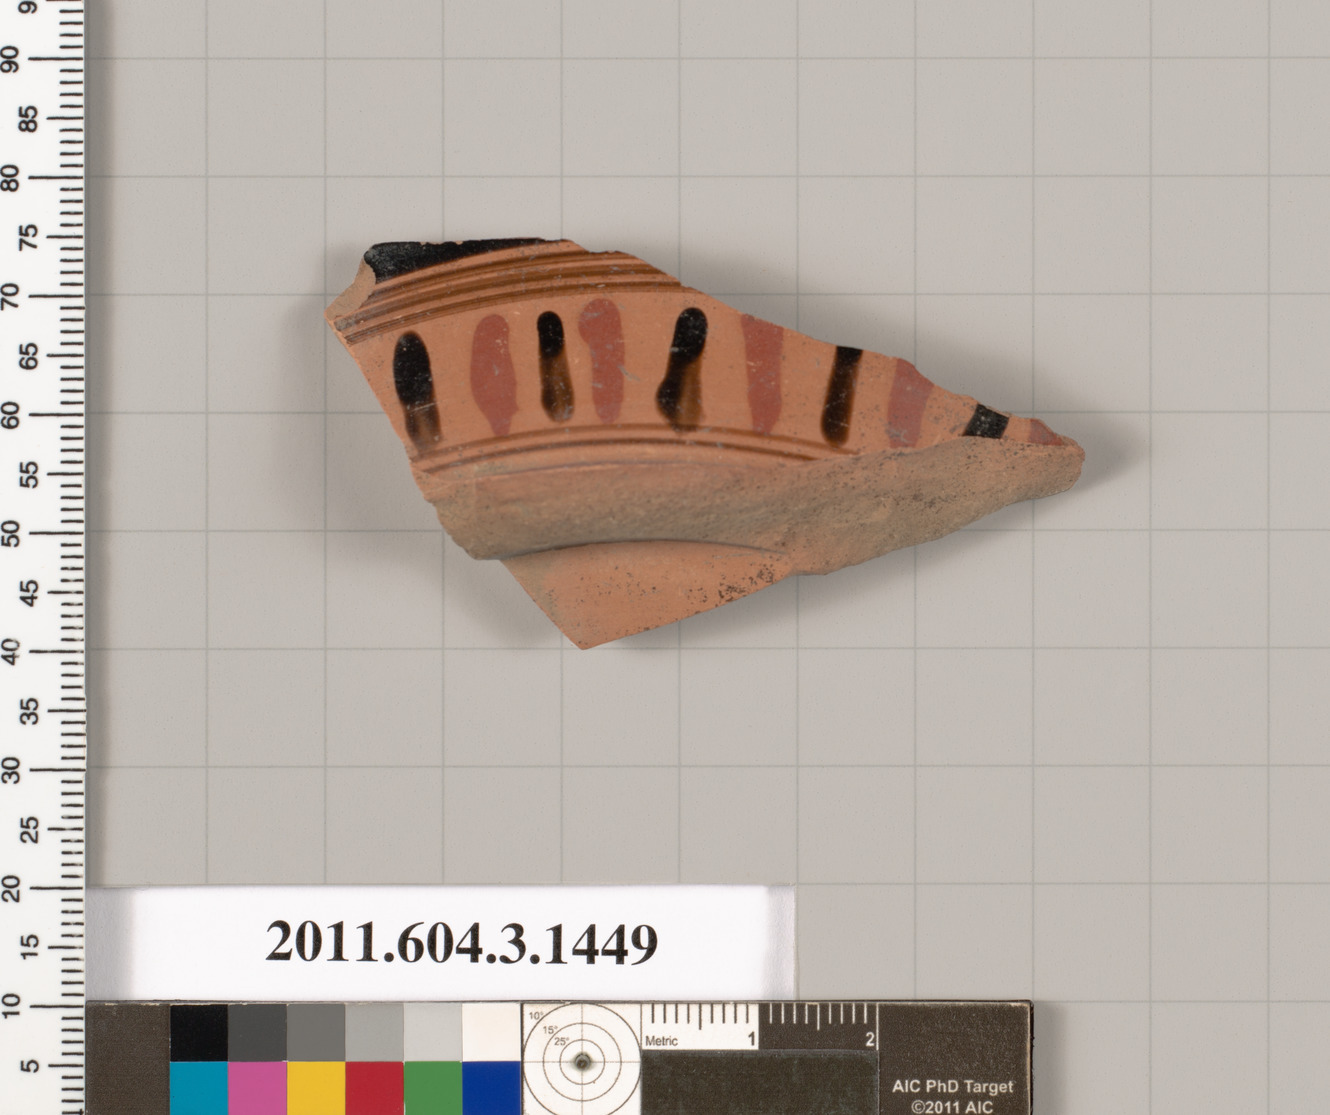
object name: skyphos fragment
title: Terracotta fragment of a skyphos (deep drinking cup)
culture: greek, attic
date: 534-468 BCE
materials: terracotta